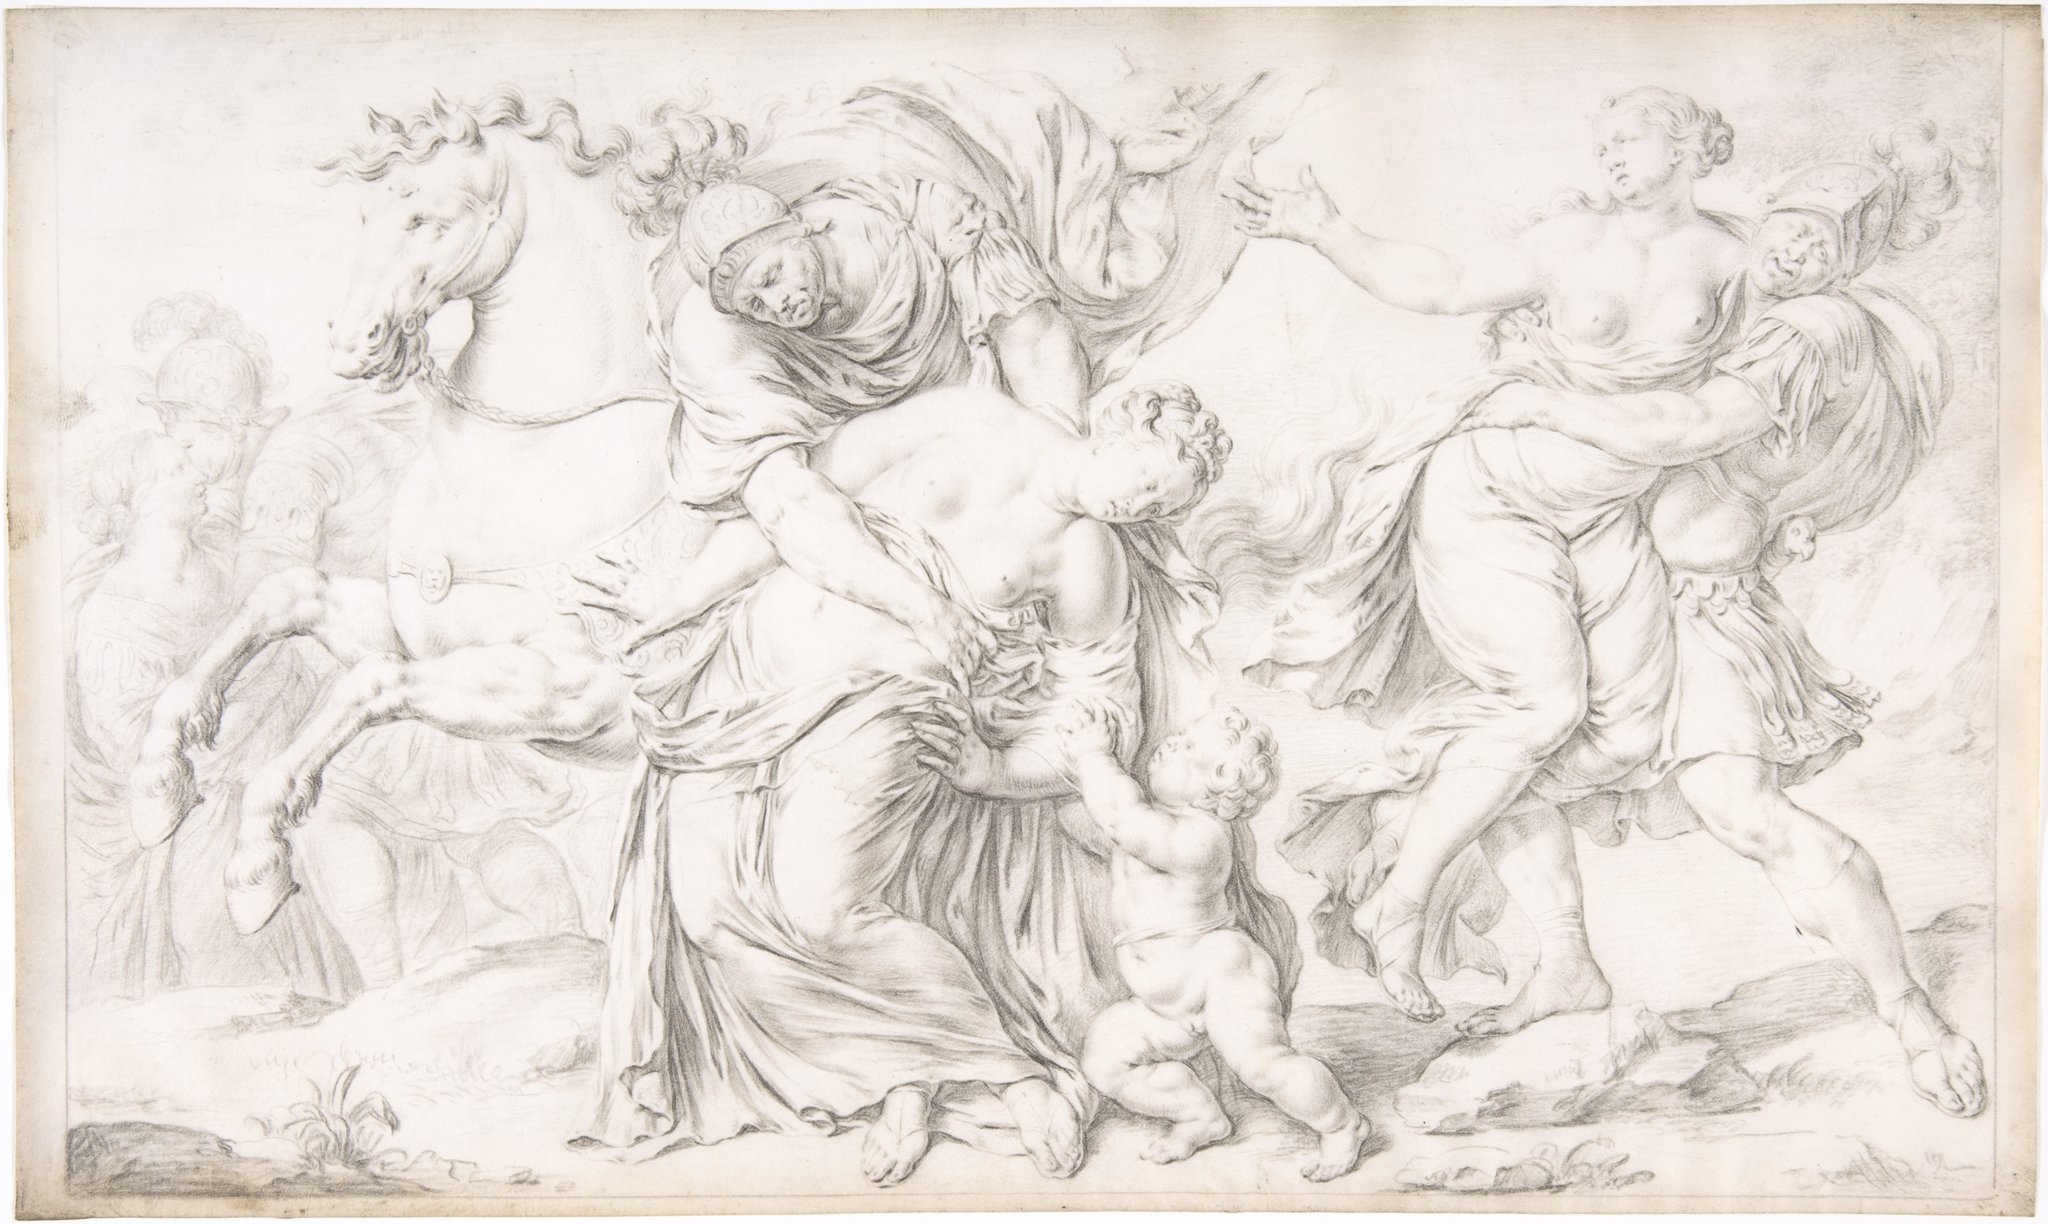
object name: drawing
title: The Rape of the Sabines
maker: willem van mieris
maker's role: artist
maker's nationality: dutch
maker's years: 1662-1747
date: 1667-1766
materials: chalk, parchment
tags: children,men,women,horses